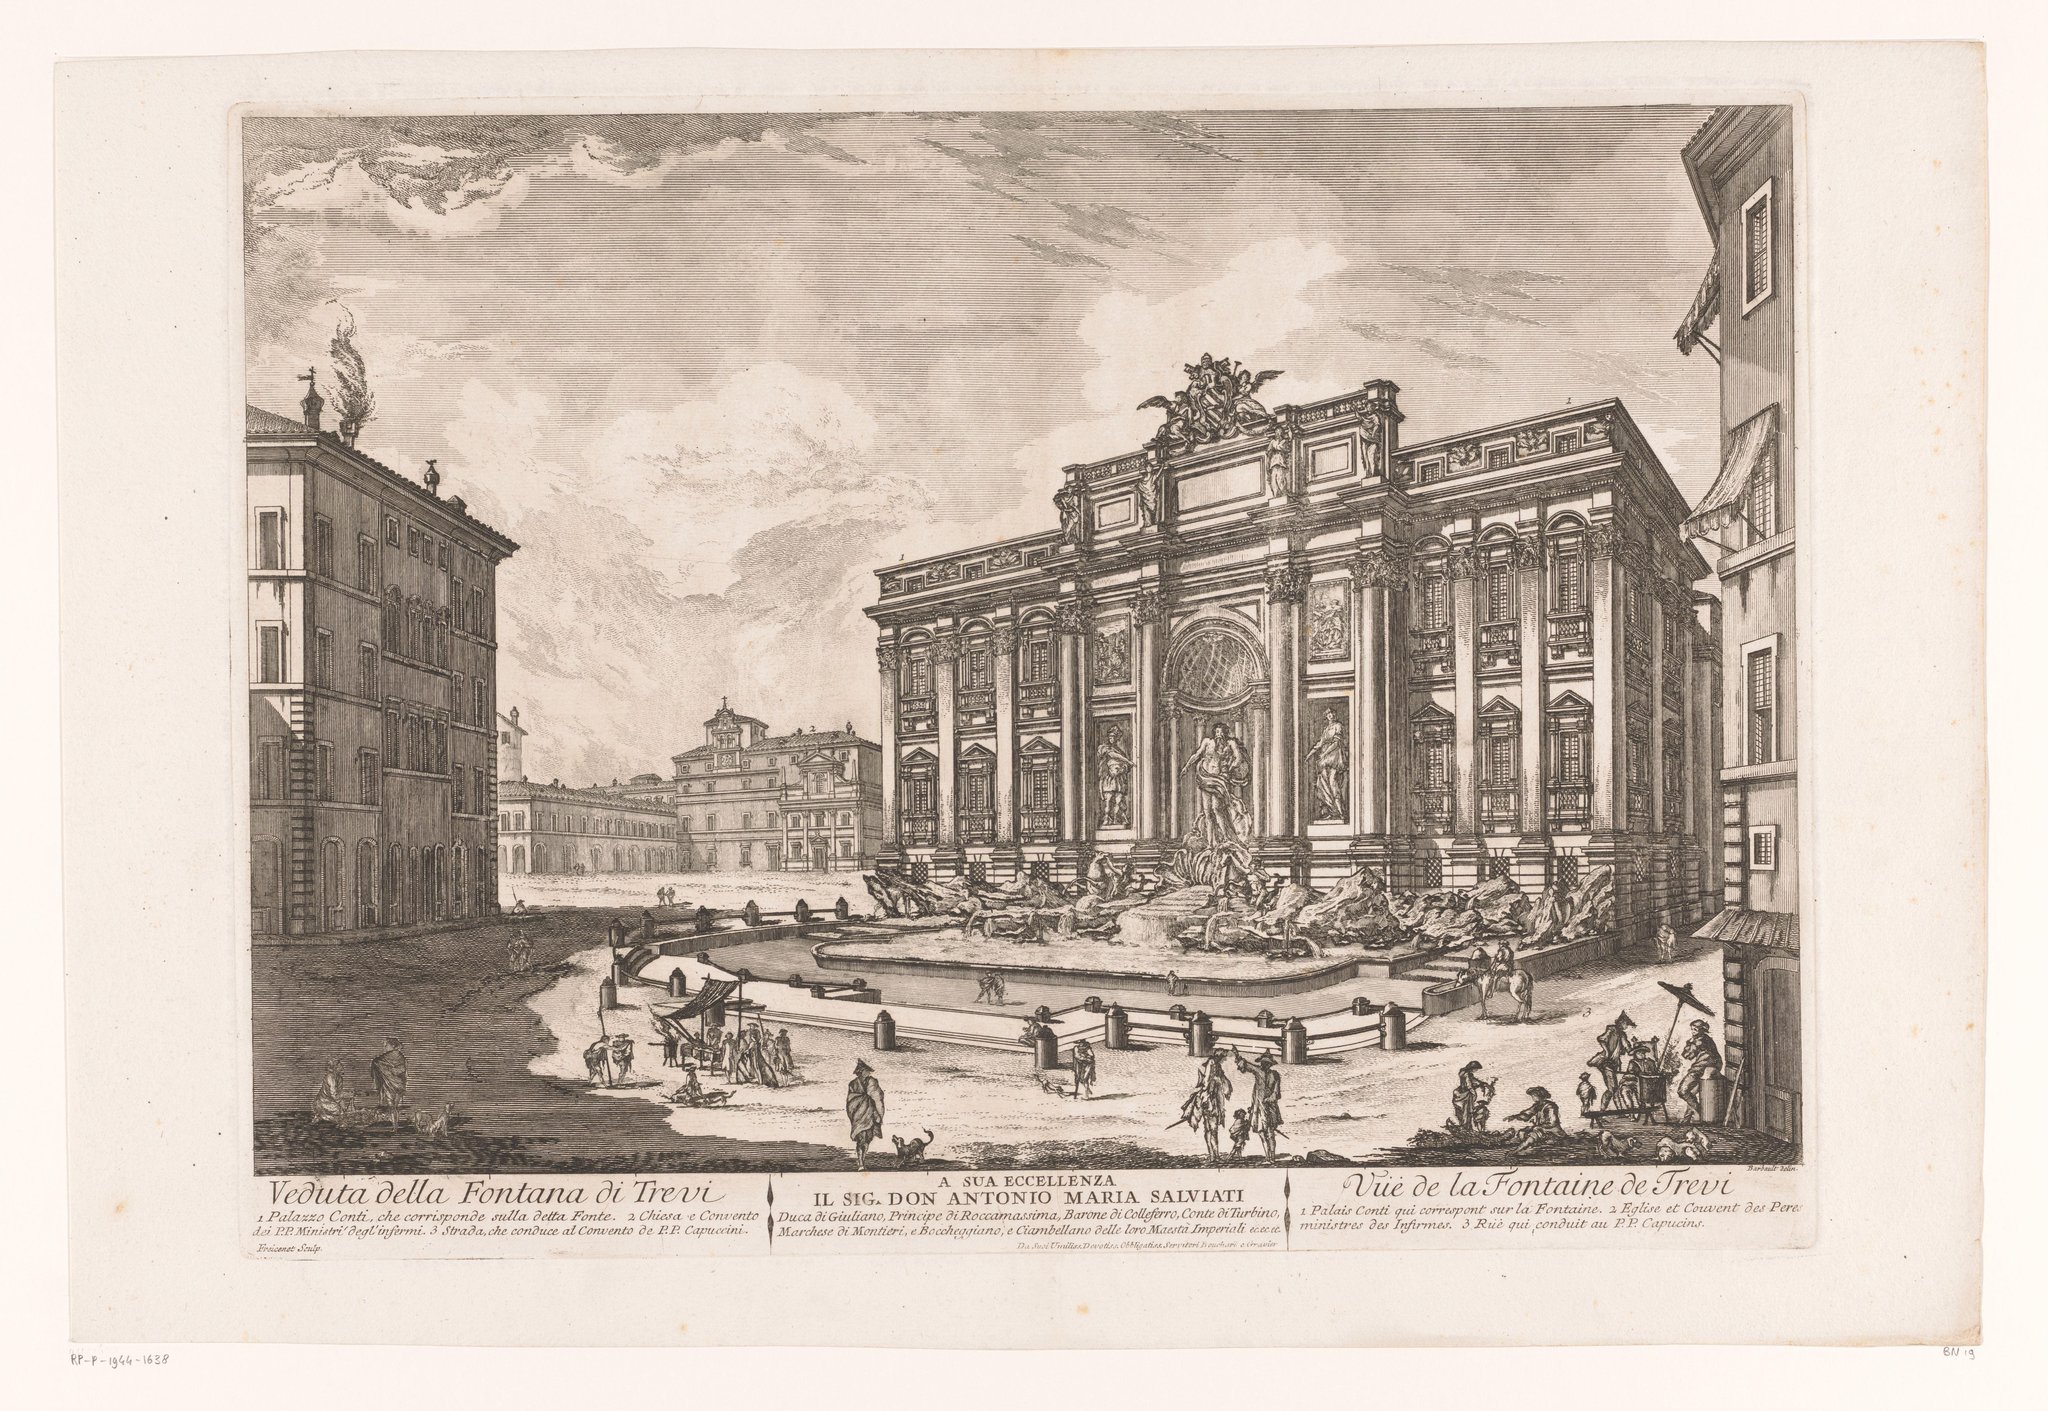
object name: book illustration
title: Veduta della Fontana di Trevi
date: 1763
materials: paper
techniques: etching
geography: rome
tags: square, place, circus, etc., city-view in general; 'veduta', church (exterior), ornamental fountain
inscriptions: collector's mark: Lugt 2228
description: Prent gebruikt voor: Barbault, Jean. Les plus beaux édifices de Rome moderne publiés par Jean Barbault peintre (...). Rome: Bouchard et Gravier, 1763.